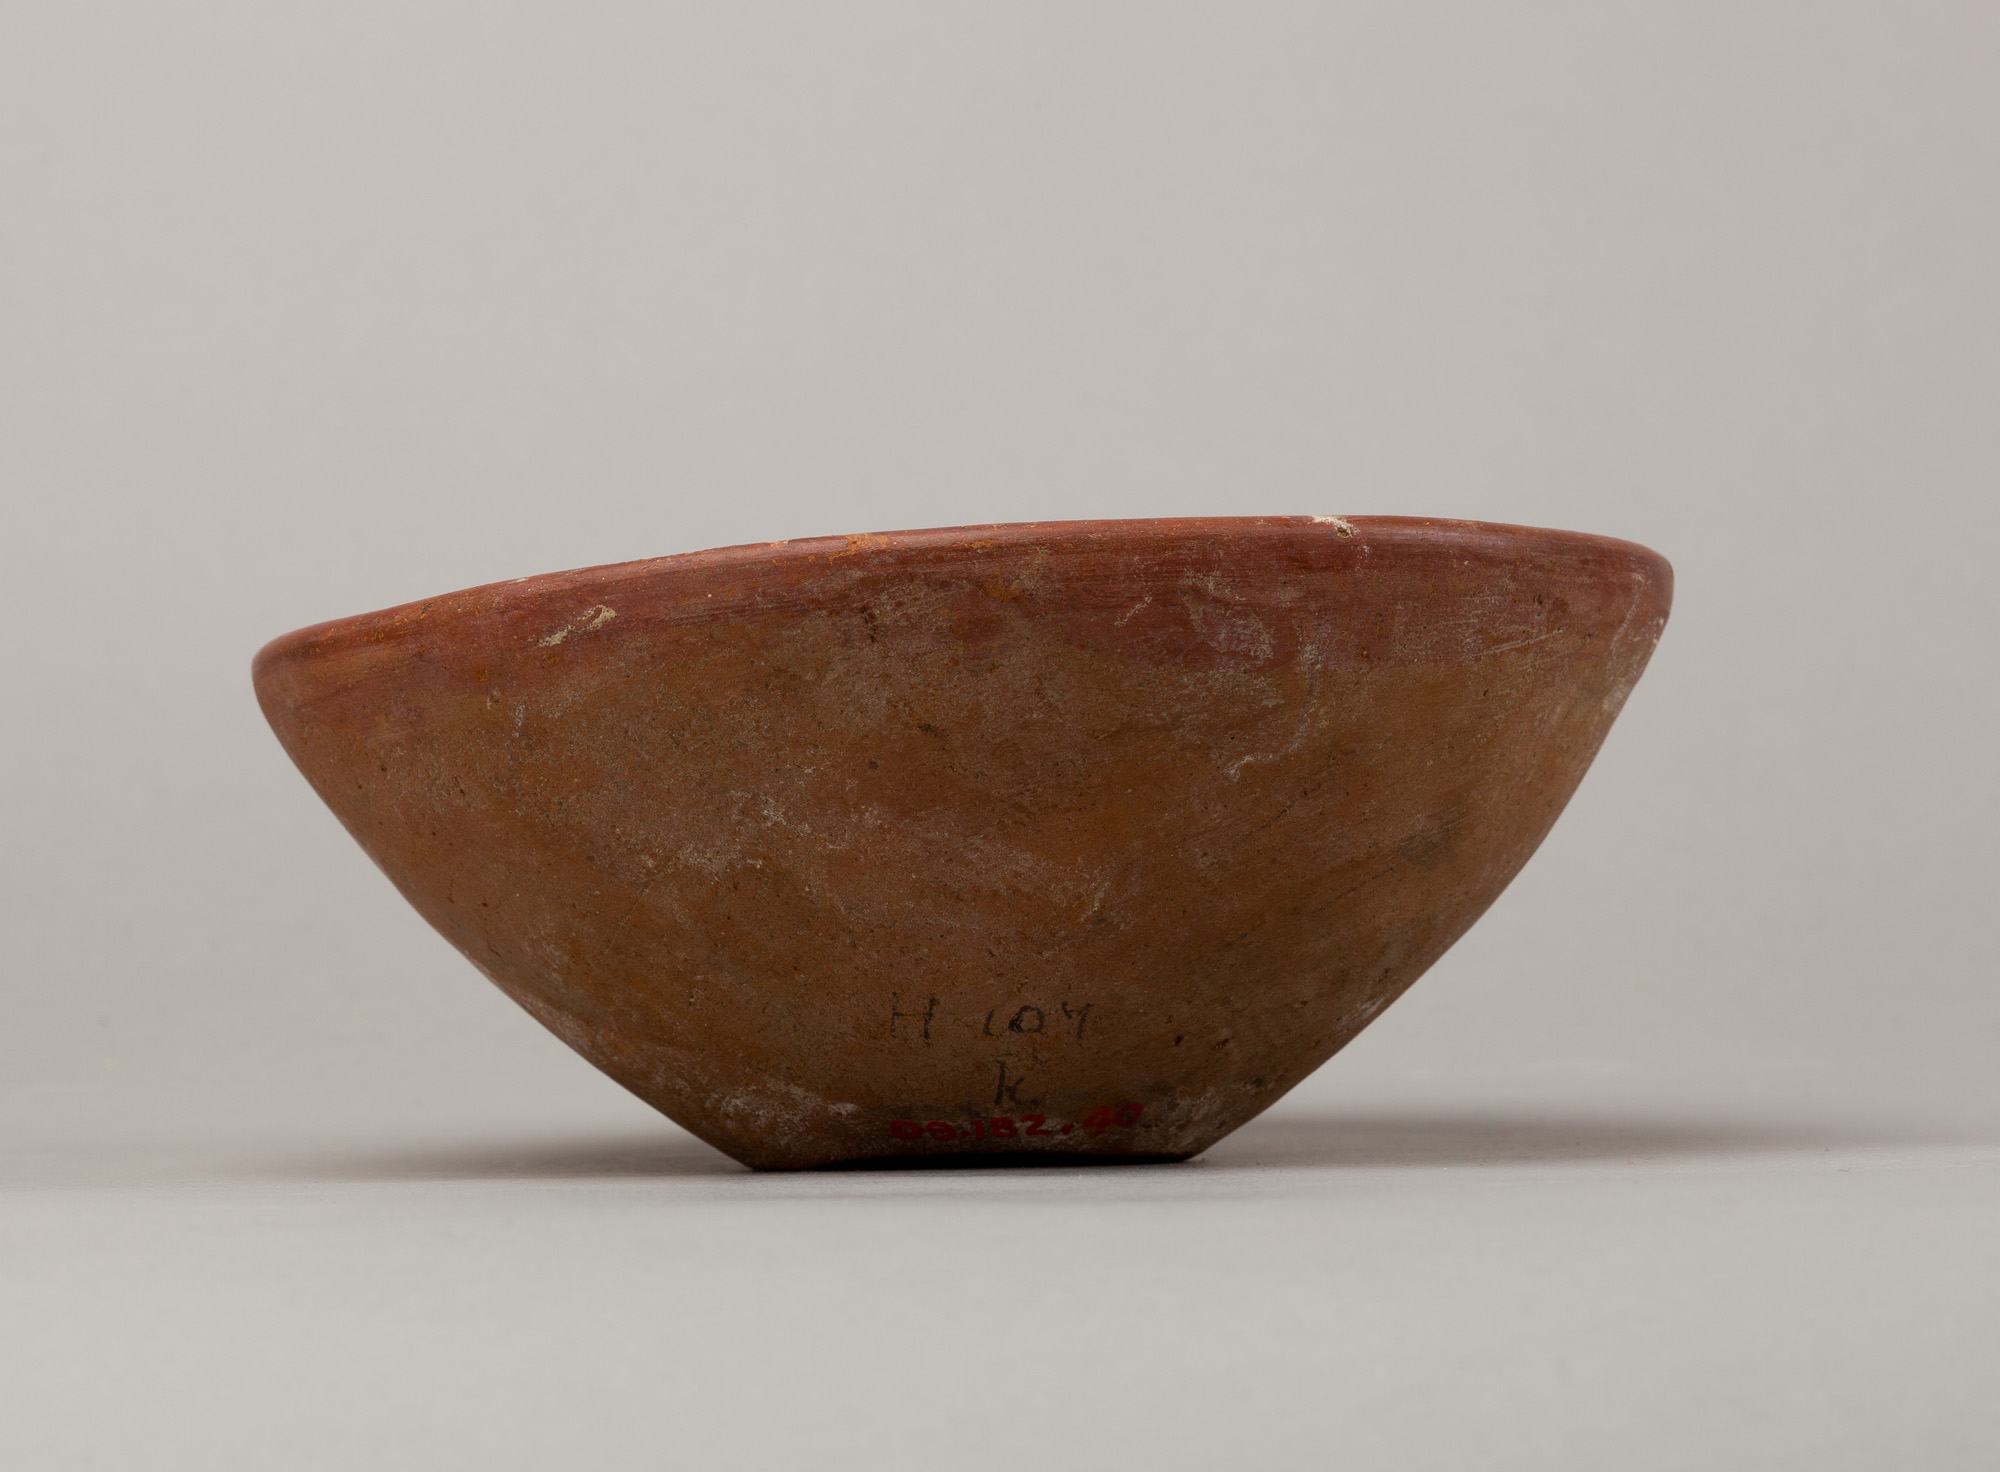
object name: bowl, red polished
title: Red polished ware bowl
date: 3850-2960 BCE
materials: pottery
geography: egypt